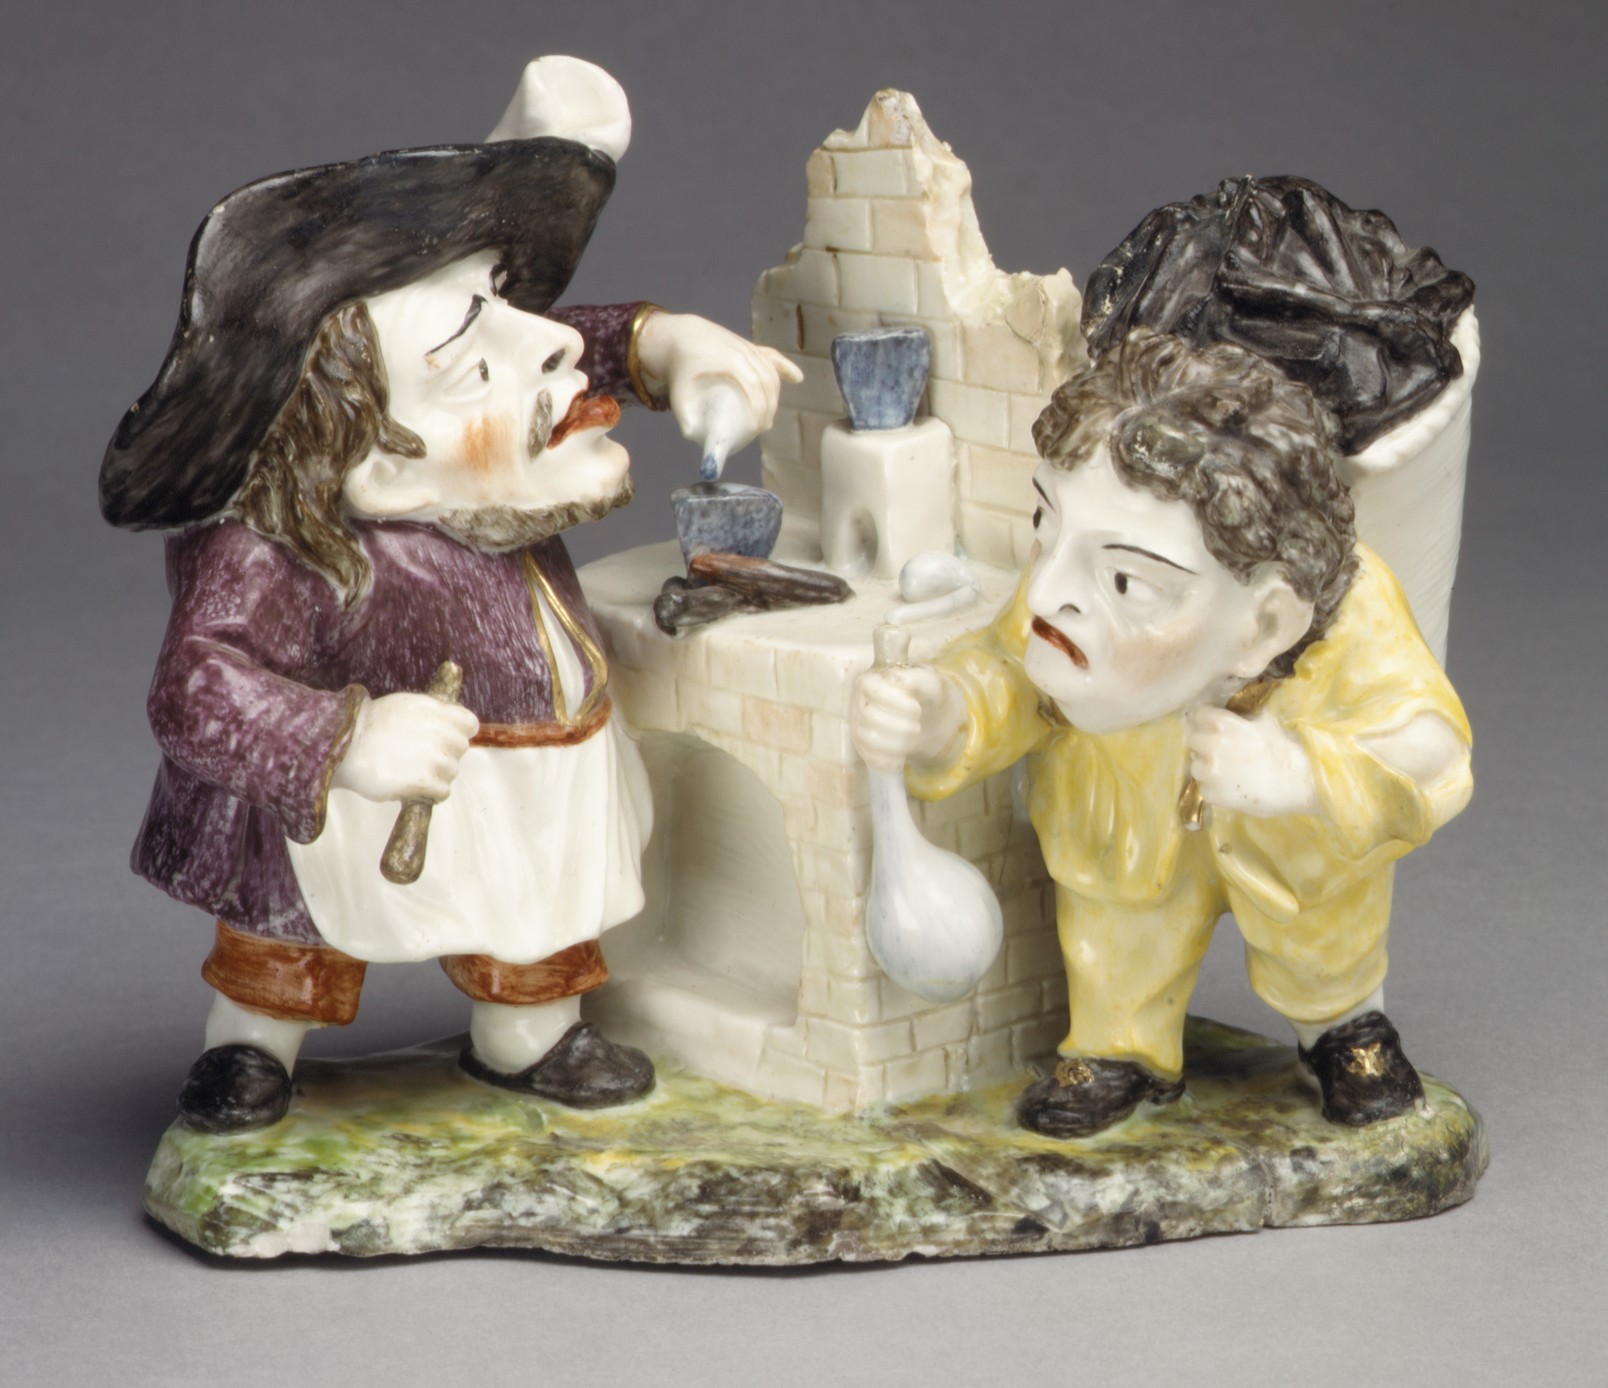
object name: group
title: Alchemists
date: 1770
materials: hard paste porcelain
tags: men